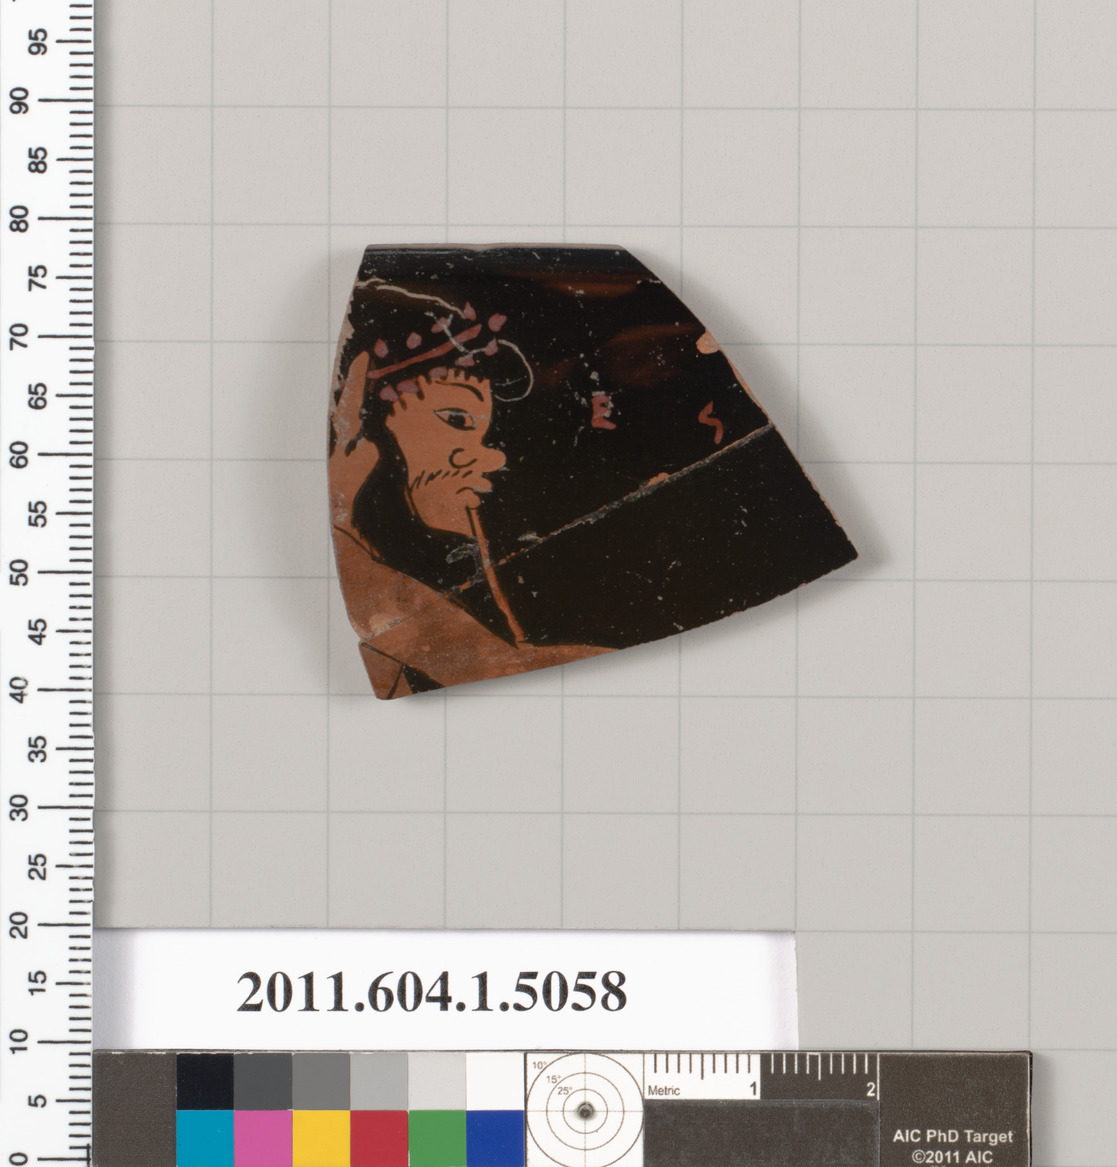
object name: kylix fragment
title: Terracotta fragment of a kylix (drinking cup)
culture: greek, attic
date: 520-500 BCE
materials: terracotta